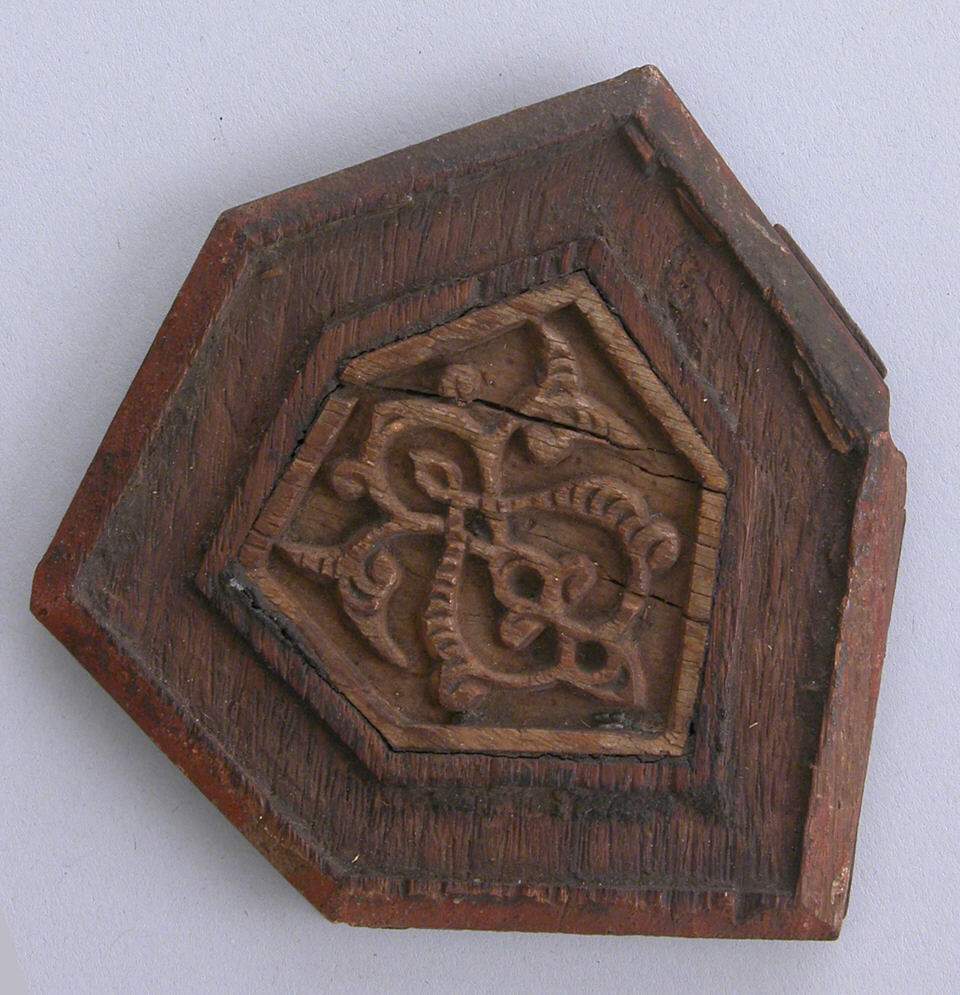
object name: panel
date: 1201-1400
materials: ivory, wood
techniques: carving, inlay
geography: egypt